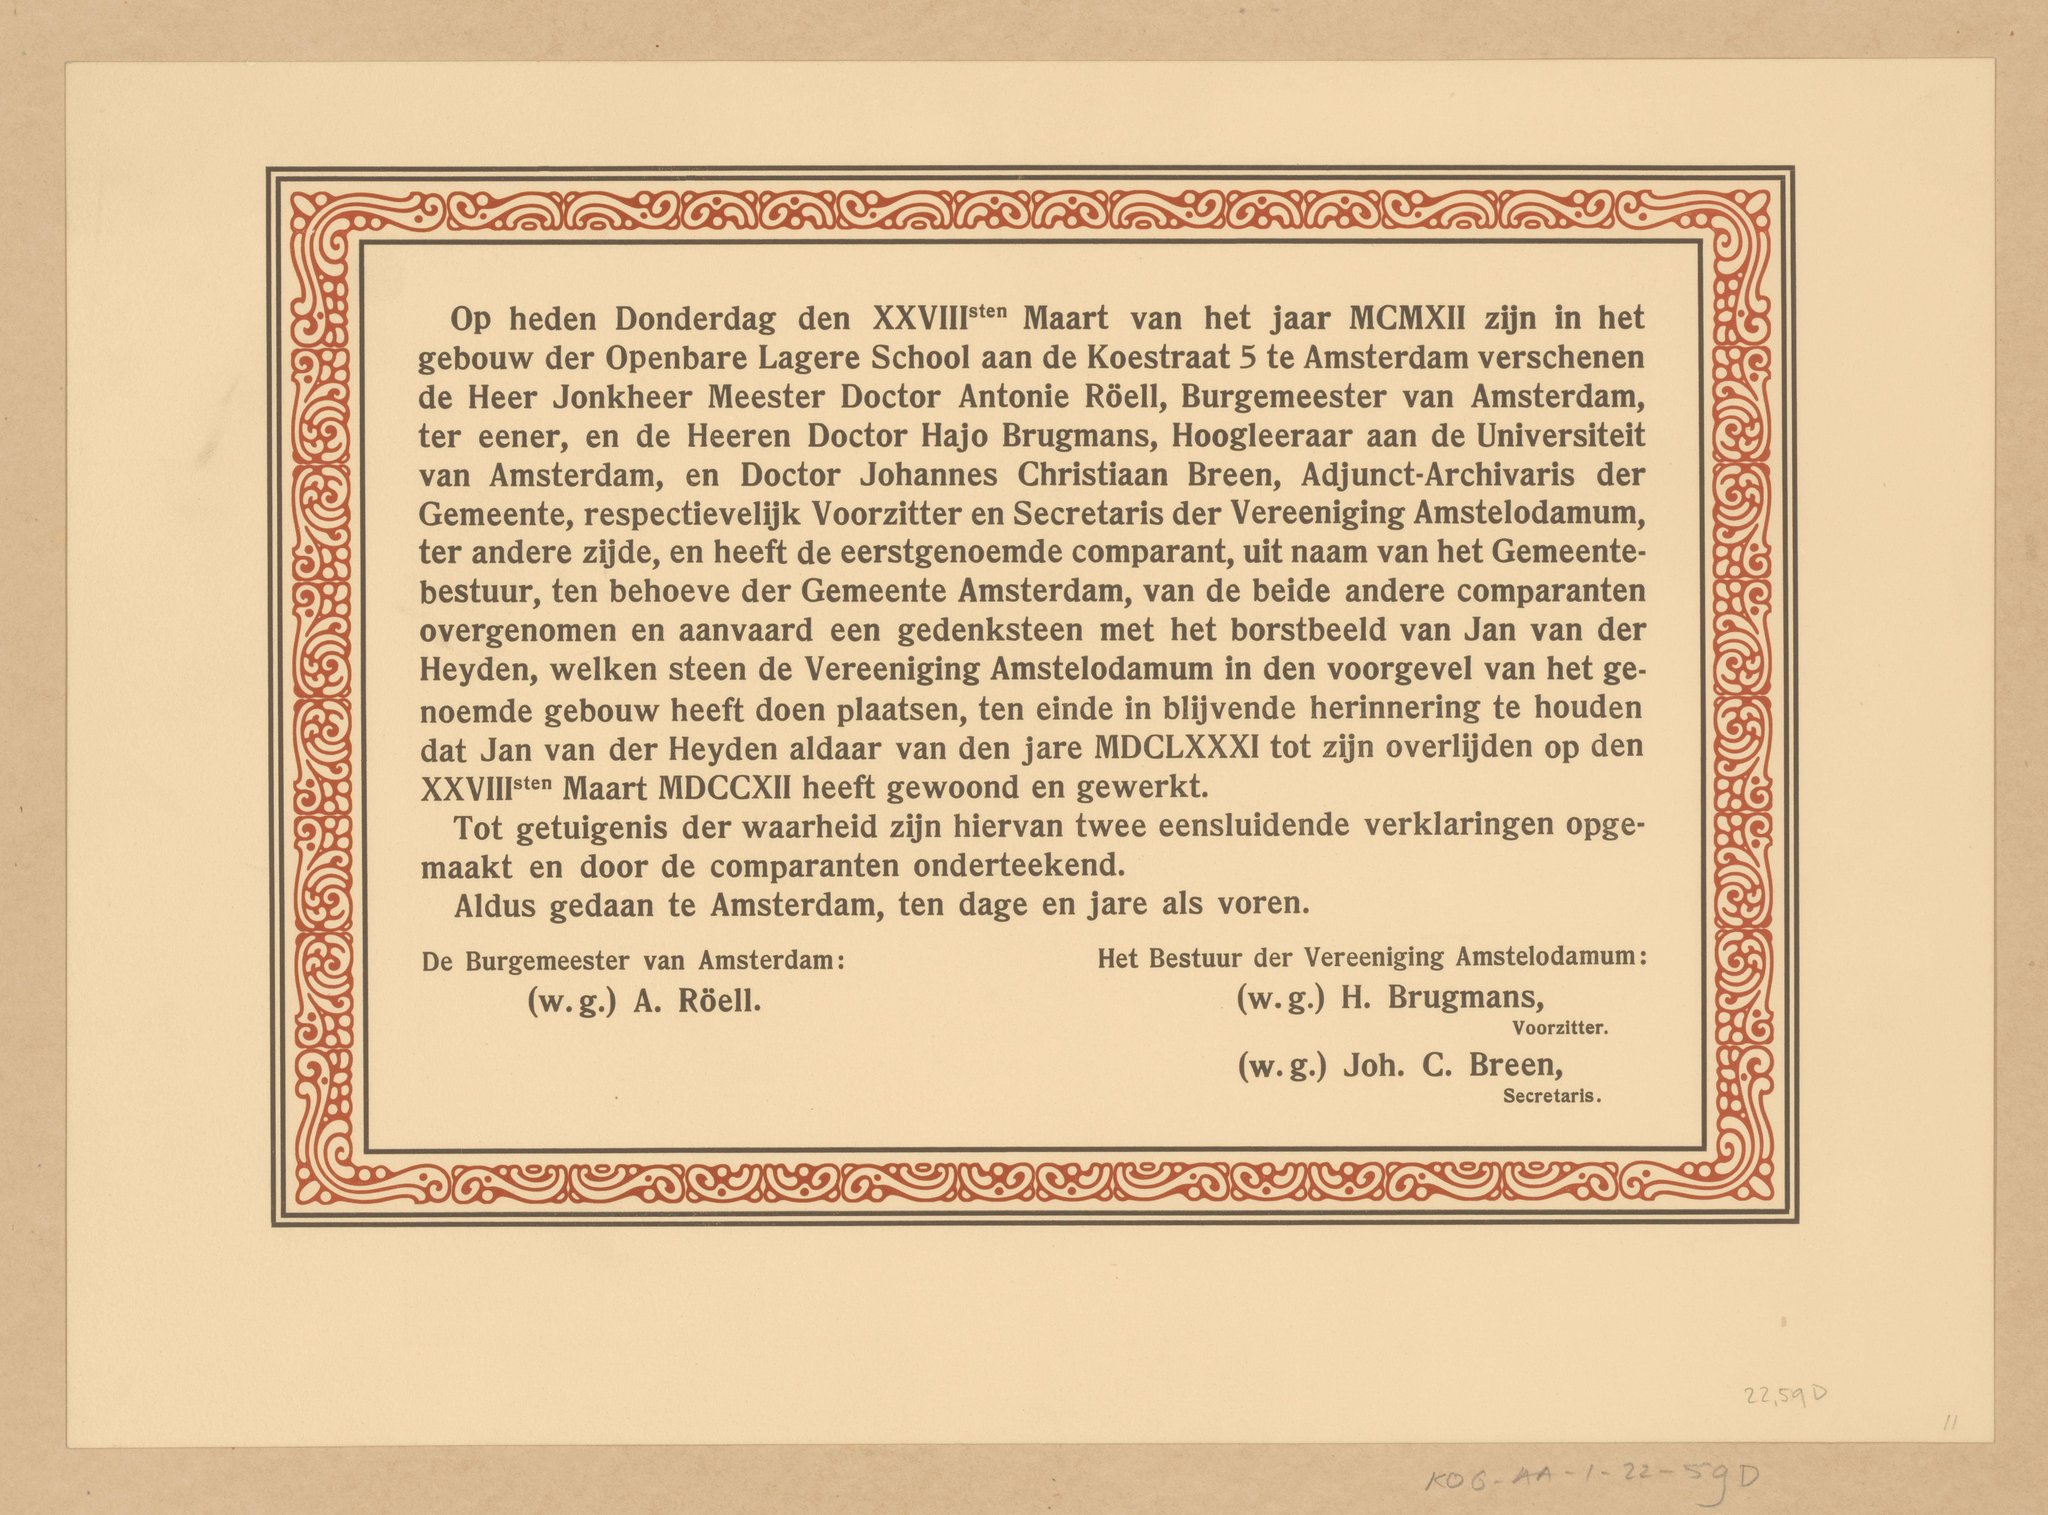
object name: text sheet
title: Bekendmaking van de overdracht van een herdenkingsmonument voor Jan van der Heyden aan het Amsterdamse gemeentebestuur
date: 1912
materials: paper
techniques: letterpress printing, printing block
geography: netherlands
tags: amsterdam, painter, draughtsman, jan van der heyden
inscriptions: collector's mark: Lugt 1641b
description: Onderwerpsrubriek binnen de Atlas Amsterdam: Gemeentewerken: A. Brandweer.